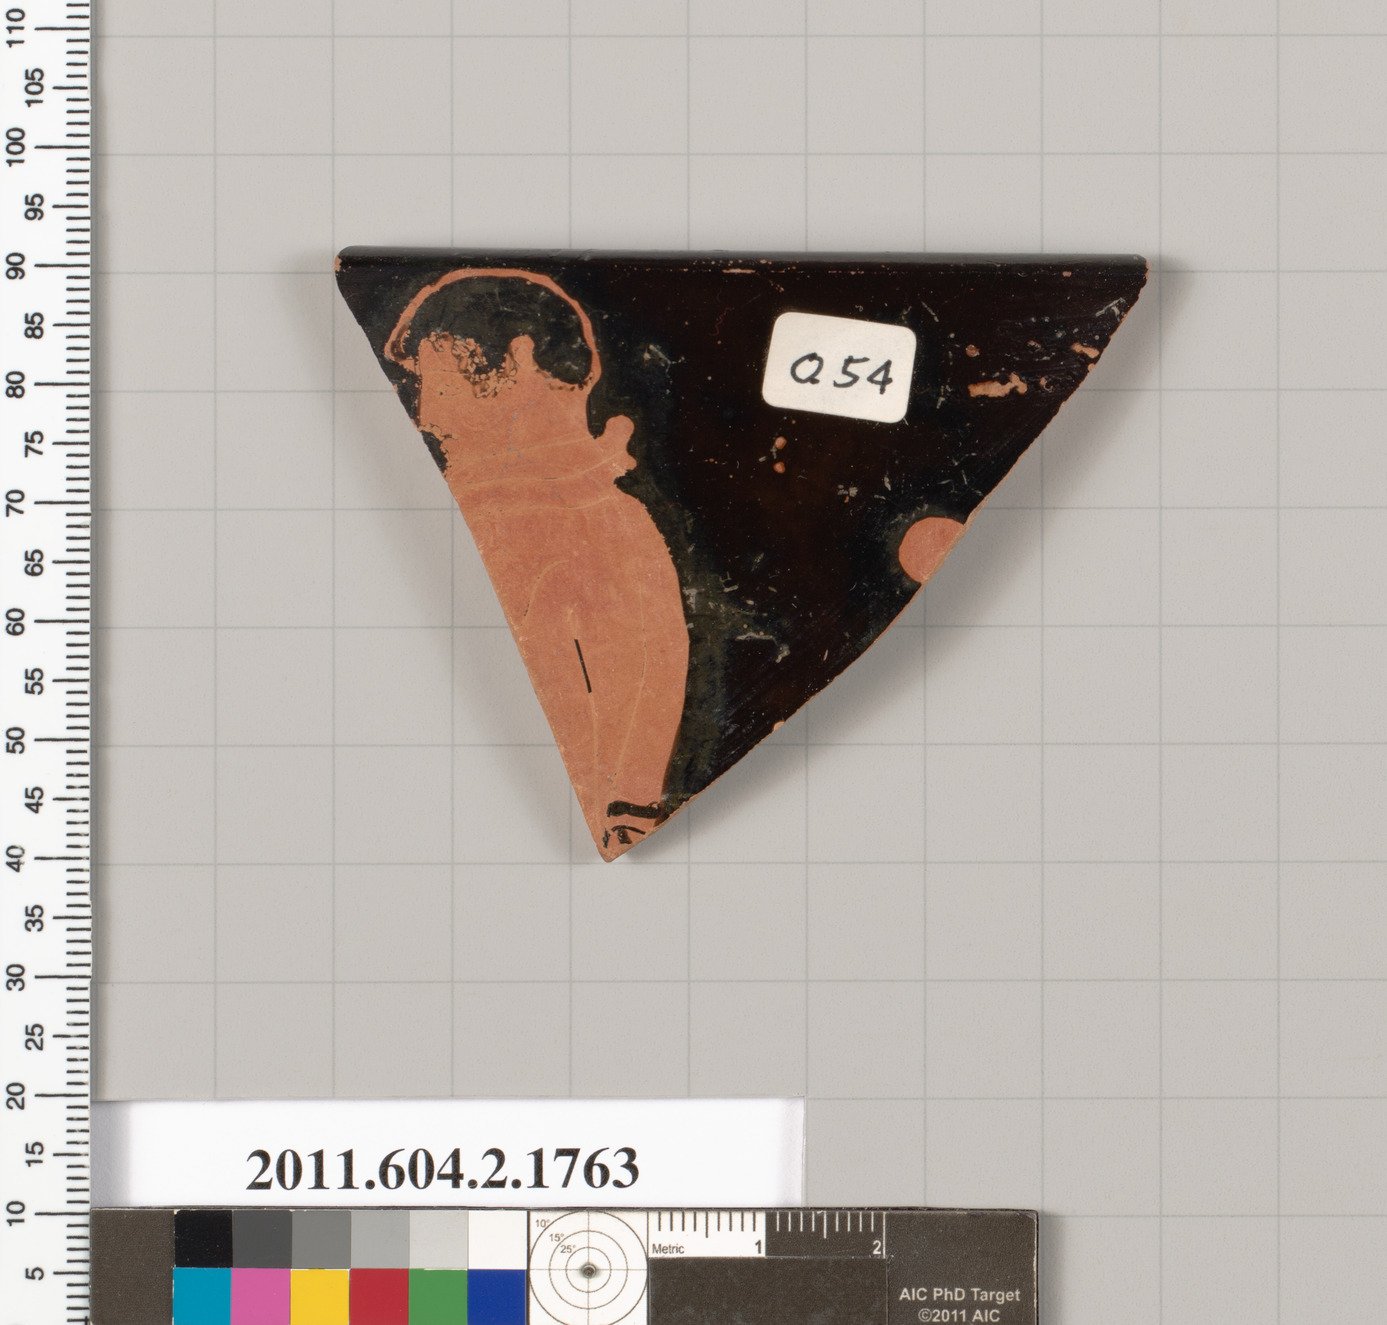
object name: skyphos fragment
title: Terracotta rim fragment of a skyphos (deep drinking cup)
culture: greek, attic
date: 475-451 BCE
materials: terracotta